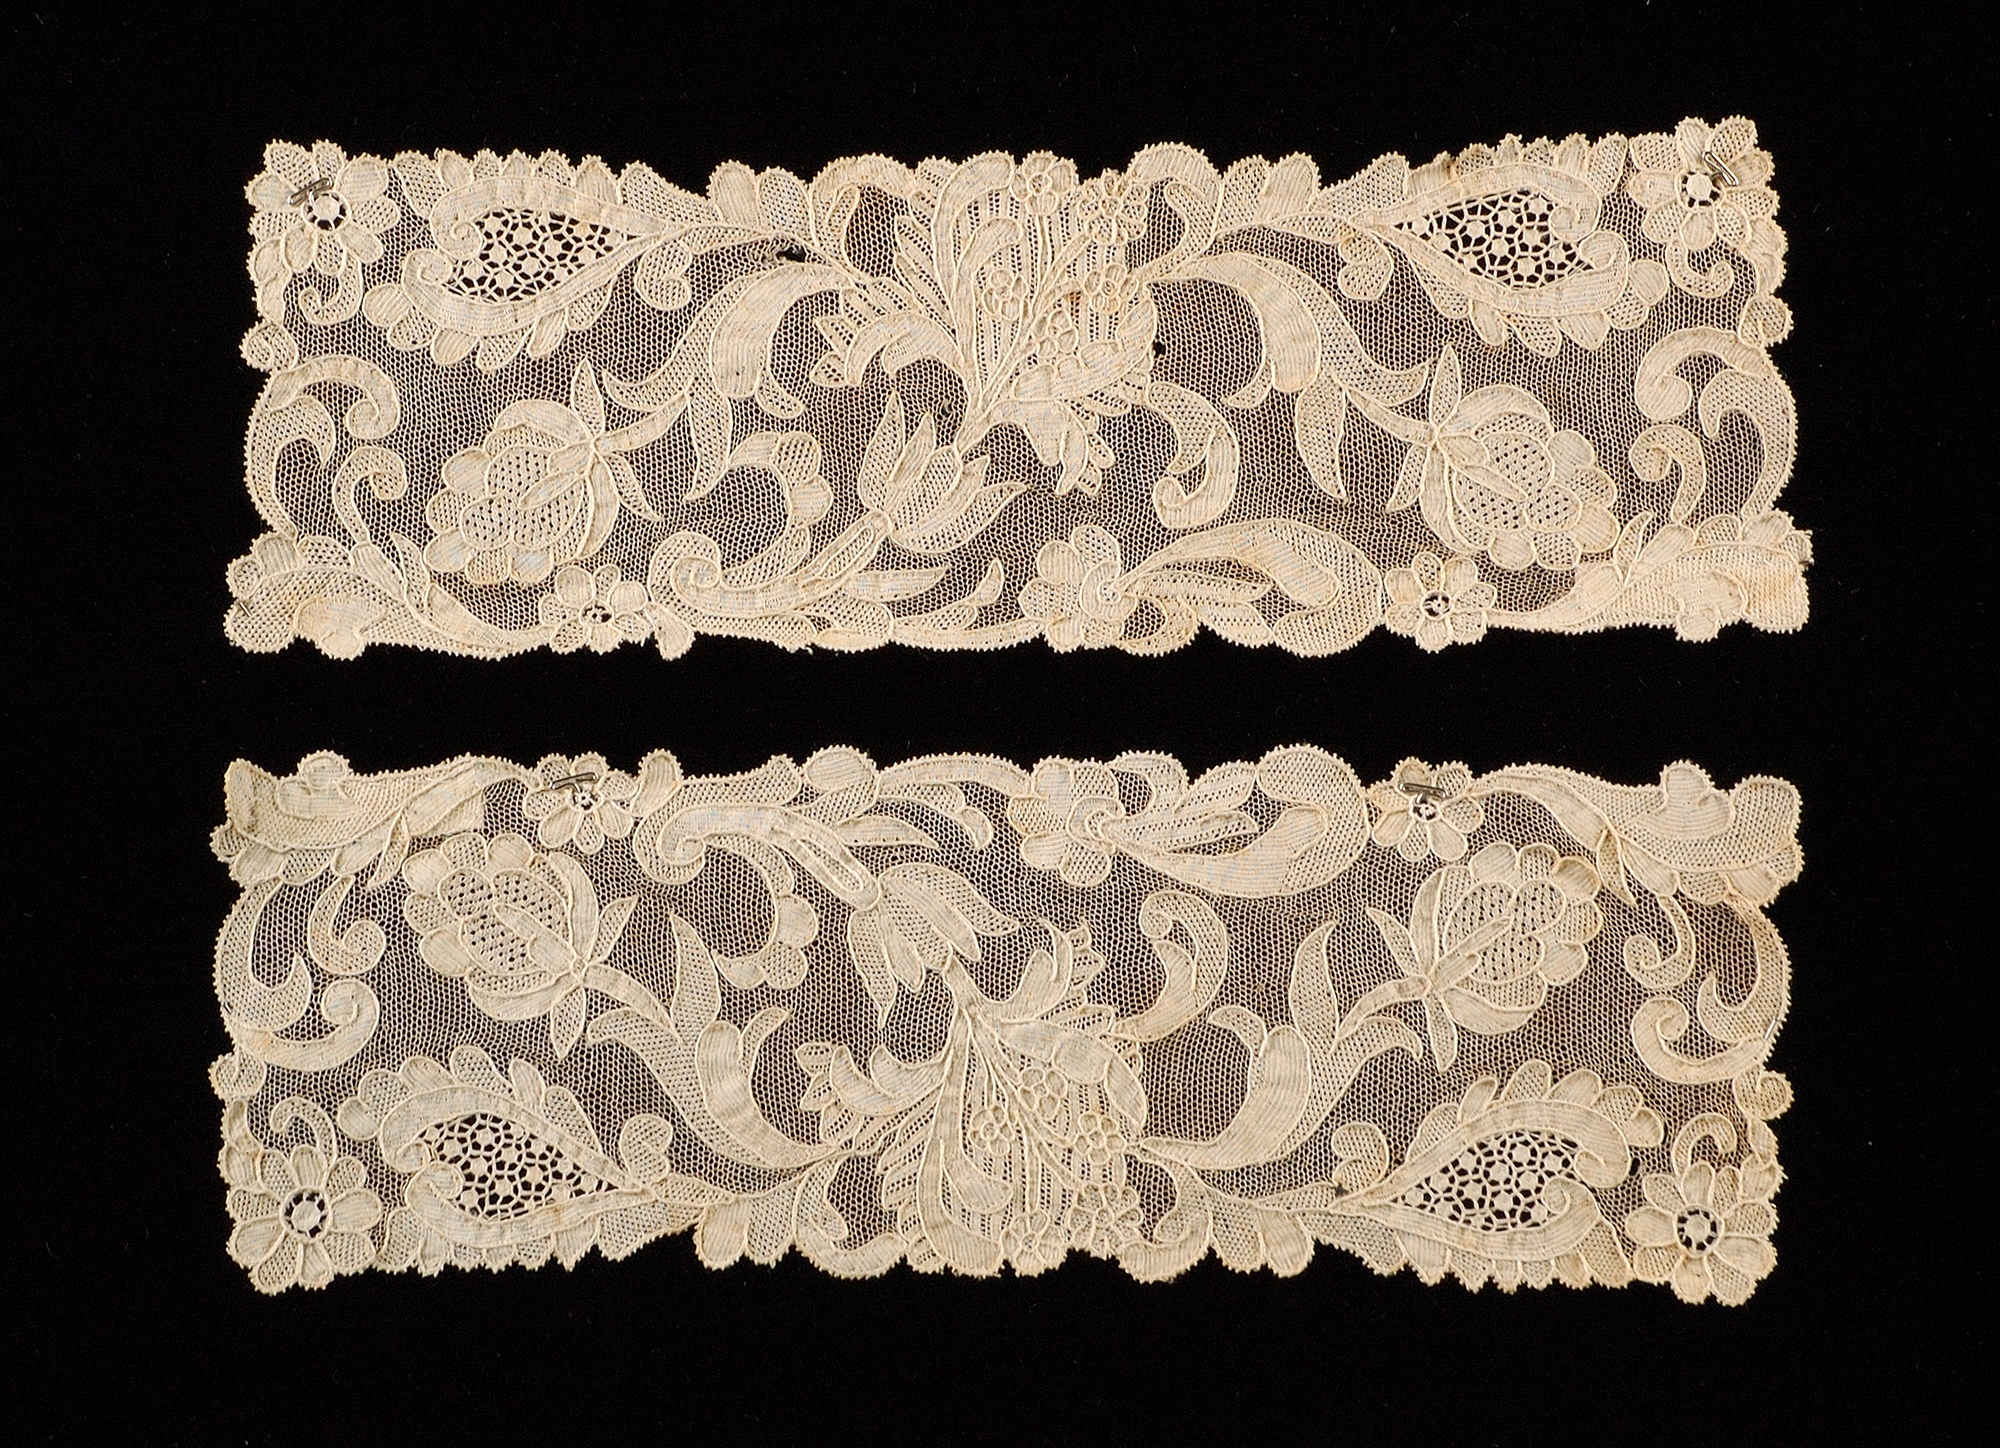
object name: accessory set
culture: italian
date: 1875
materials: linen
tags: flowers